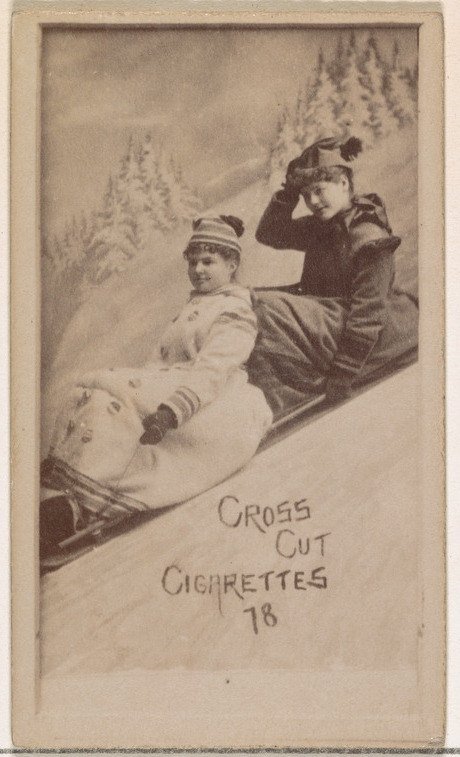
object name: print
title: Card Number 78, from the Actors and Actresses series (N145-1) issued by Duke Sons & Co. to promote Cross Cut Cigarettes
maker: w. duke, sons & co.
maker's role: publisher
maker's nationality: american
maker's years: 1870-1920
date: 1880-1889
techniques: albumen silver print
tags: portraits,women,actresses